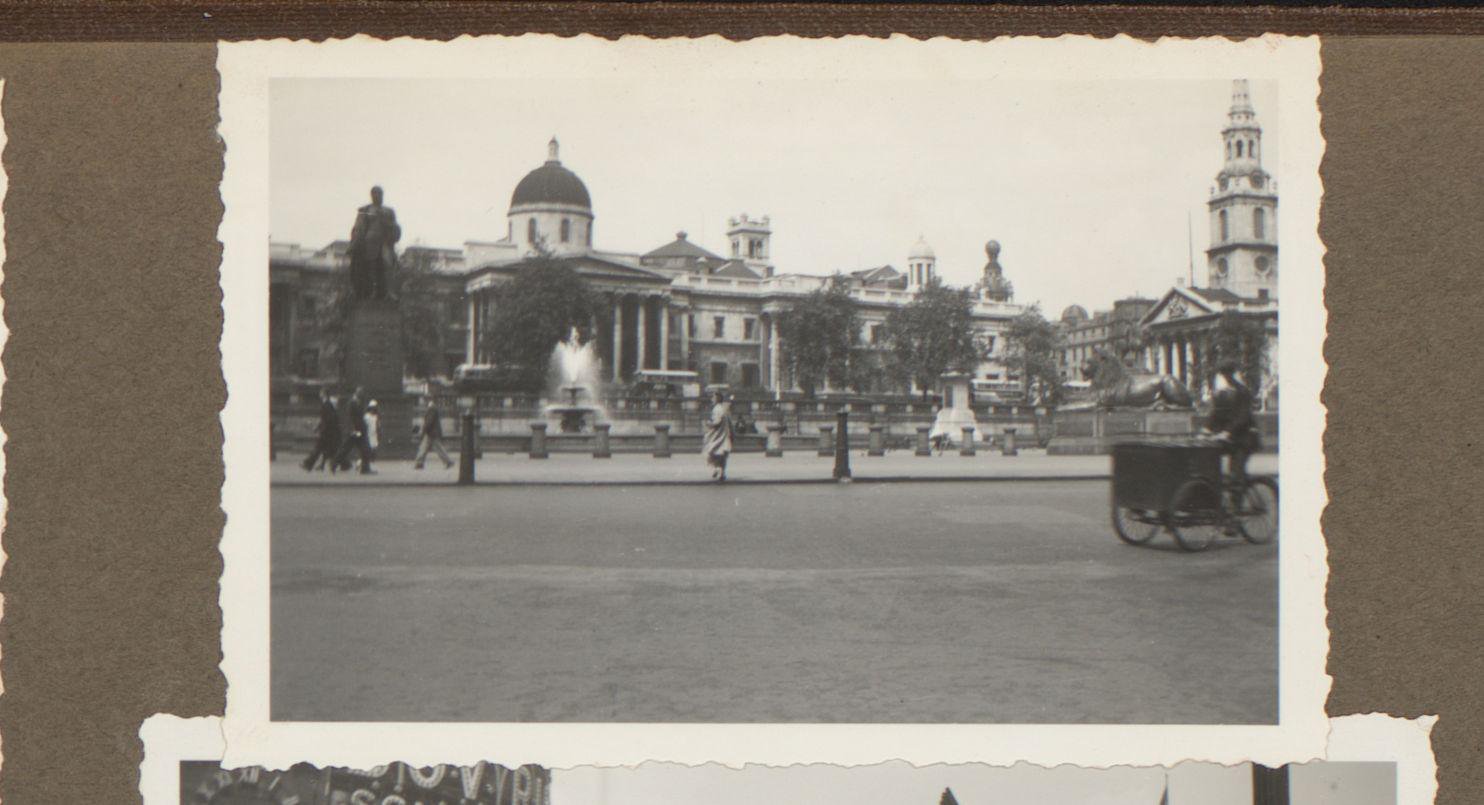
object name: album leaf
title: Gezicht op Trafalgar Square, Londen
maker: Anonymous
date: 1906-1933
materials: paper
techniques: gelatin silver print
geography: london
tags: square, place, circus, etc.